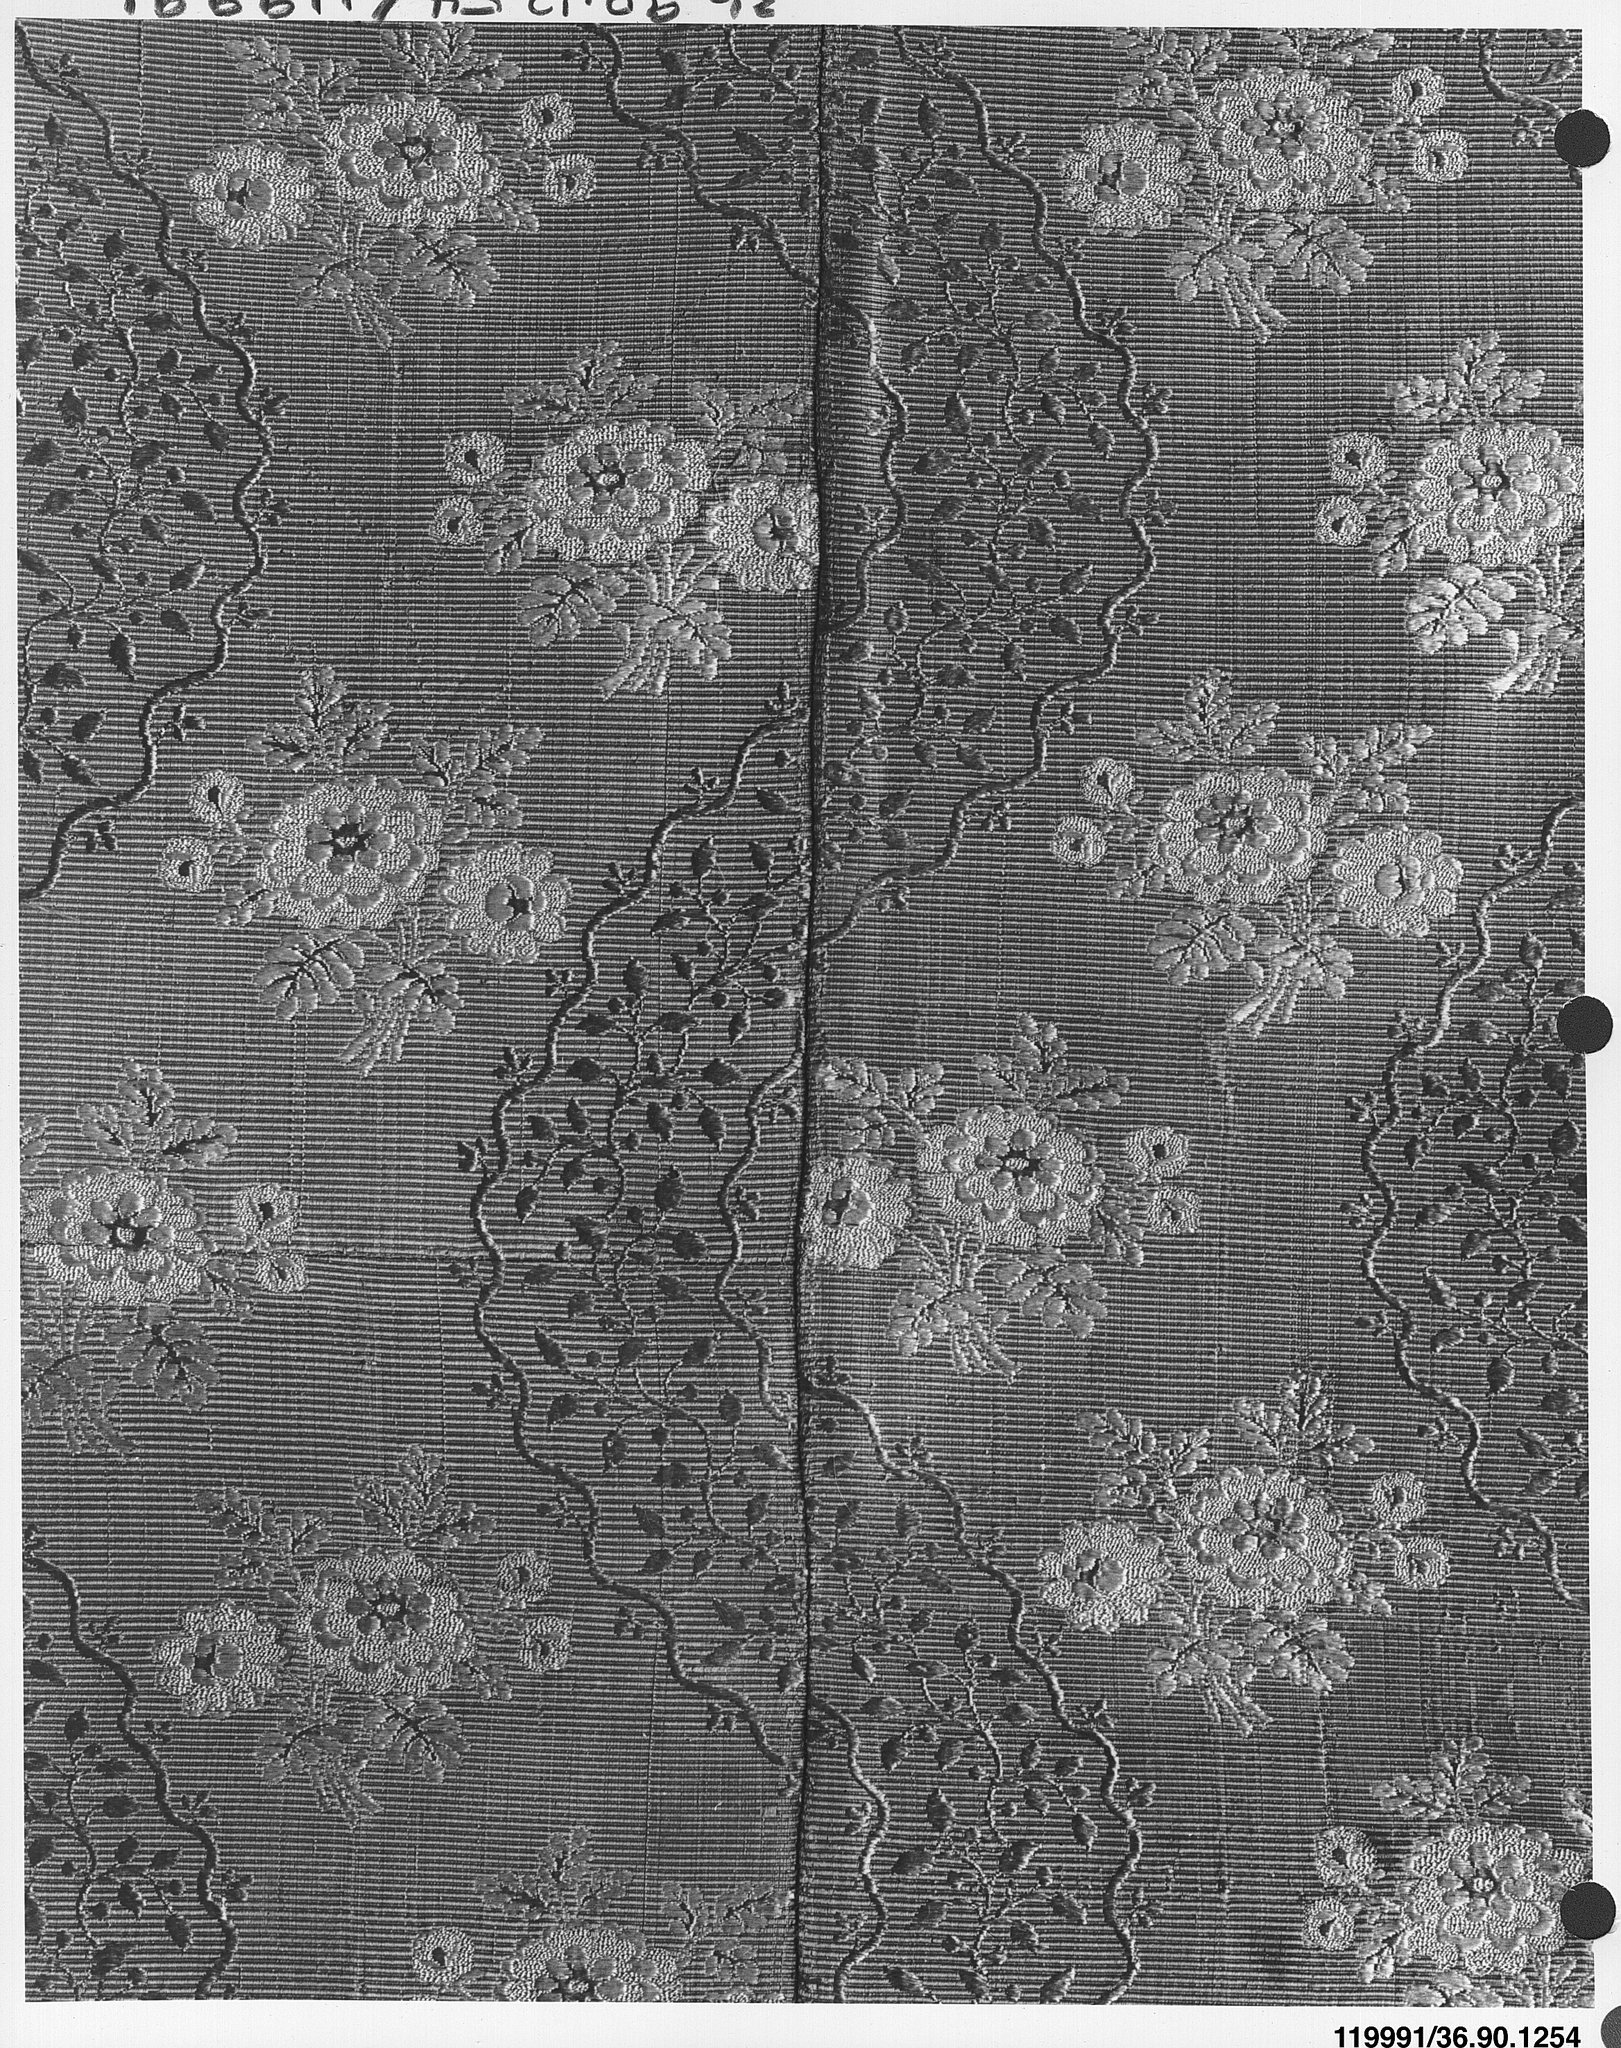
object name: piece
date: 1760-1770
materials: silk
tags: flowers,leaves